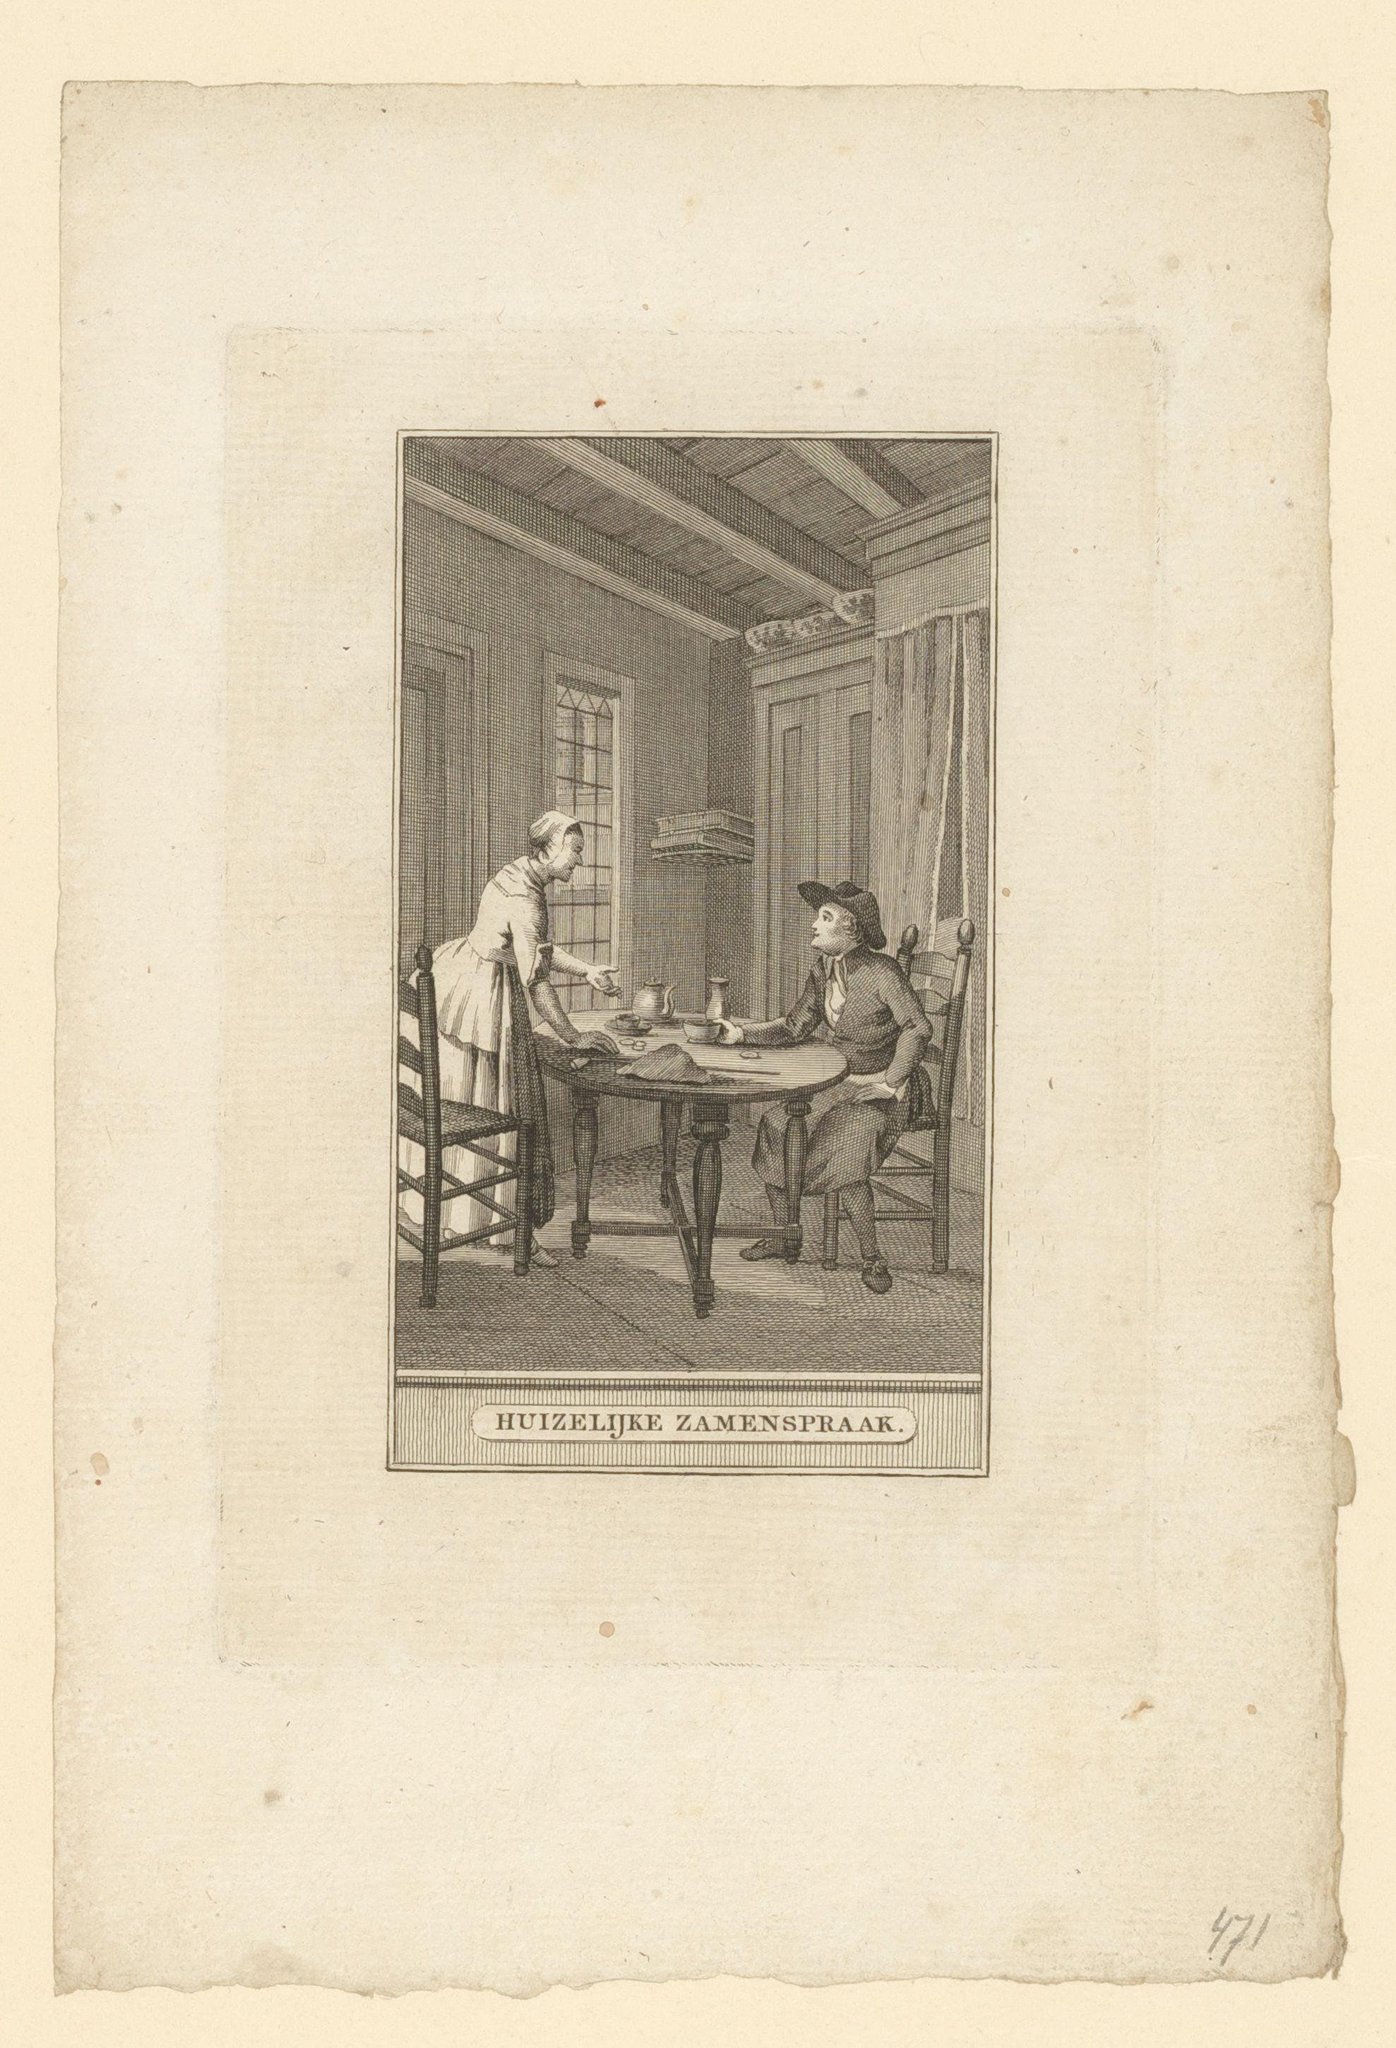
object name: print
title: Huizelijke Zamenspraak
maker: Anonymous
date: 1792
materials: paper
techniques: engraving, etching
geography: netherlands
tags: communal rooms, family life at home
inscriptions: collector's mark, collector's mark: Lugt 1641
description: Gebruikt als illustratie in: E. Bekker en A. Deken, Economische liedjes, Den Haag: Isaac van Cleef, 1792, dl. 1. p. 106/107.